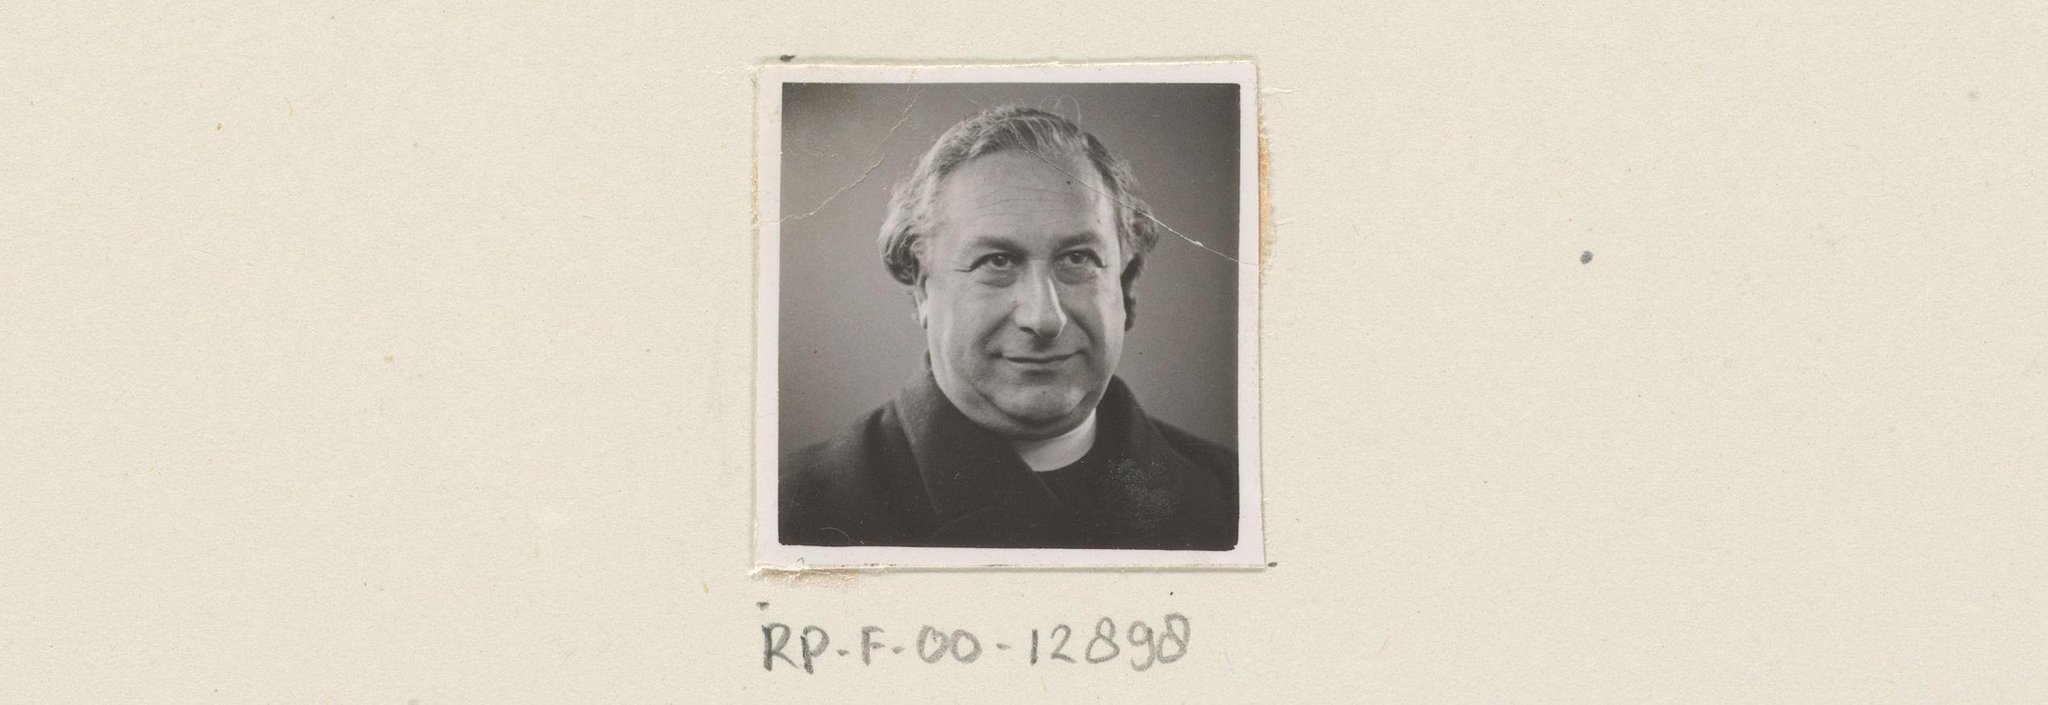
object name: photograph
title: Portret van Jacobus van Ginneken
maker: Anonymous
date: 1920-1945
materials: paper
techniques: gelatin silver print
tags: nijmegen, priest, historical persons, politician, e.g. party leader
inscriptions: inscription: ‘Jac. van Ginneken’